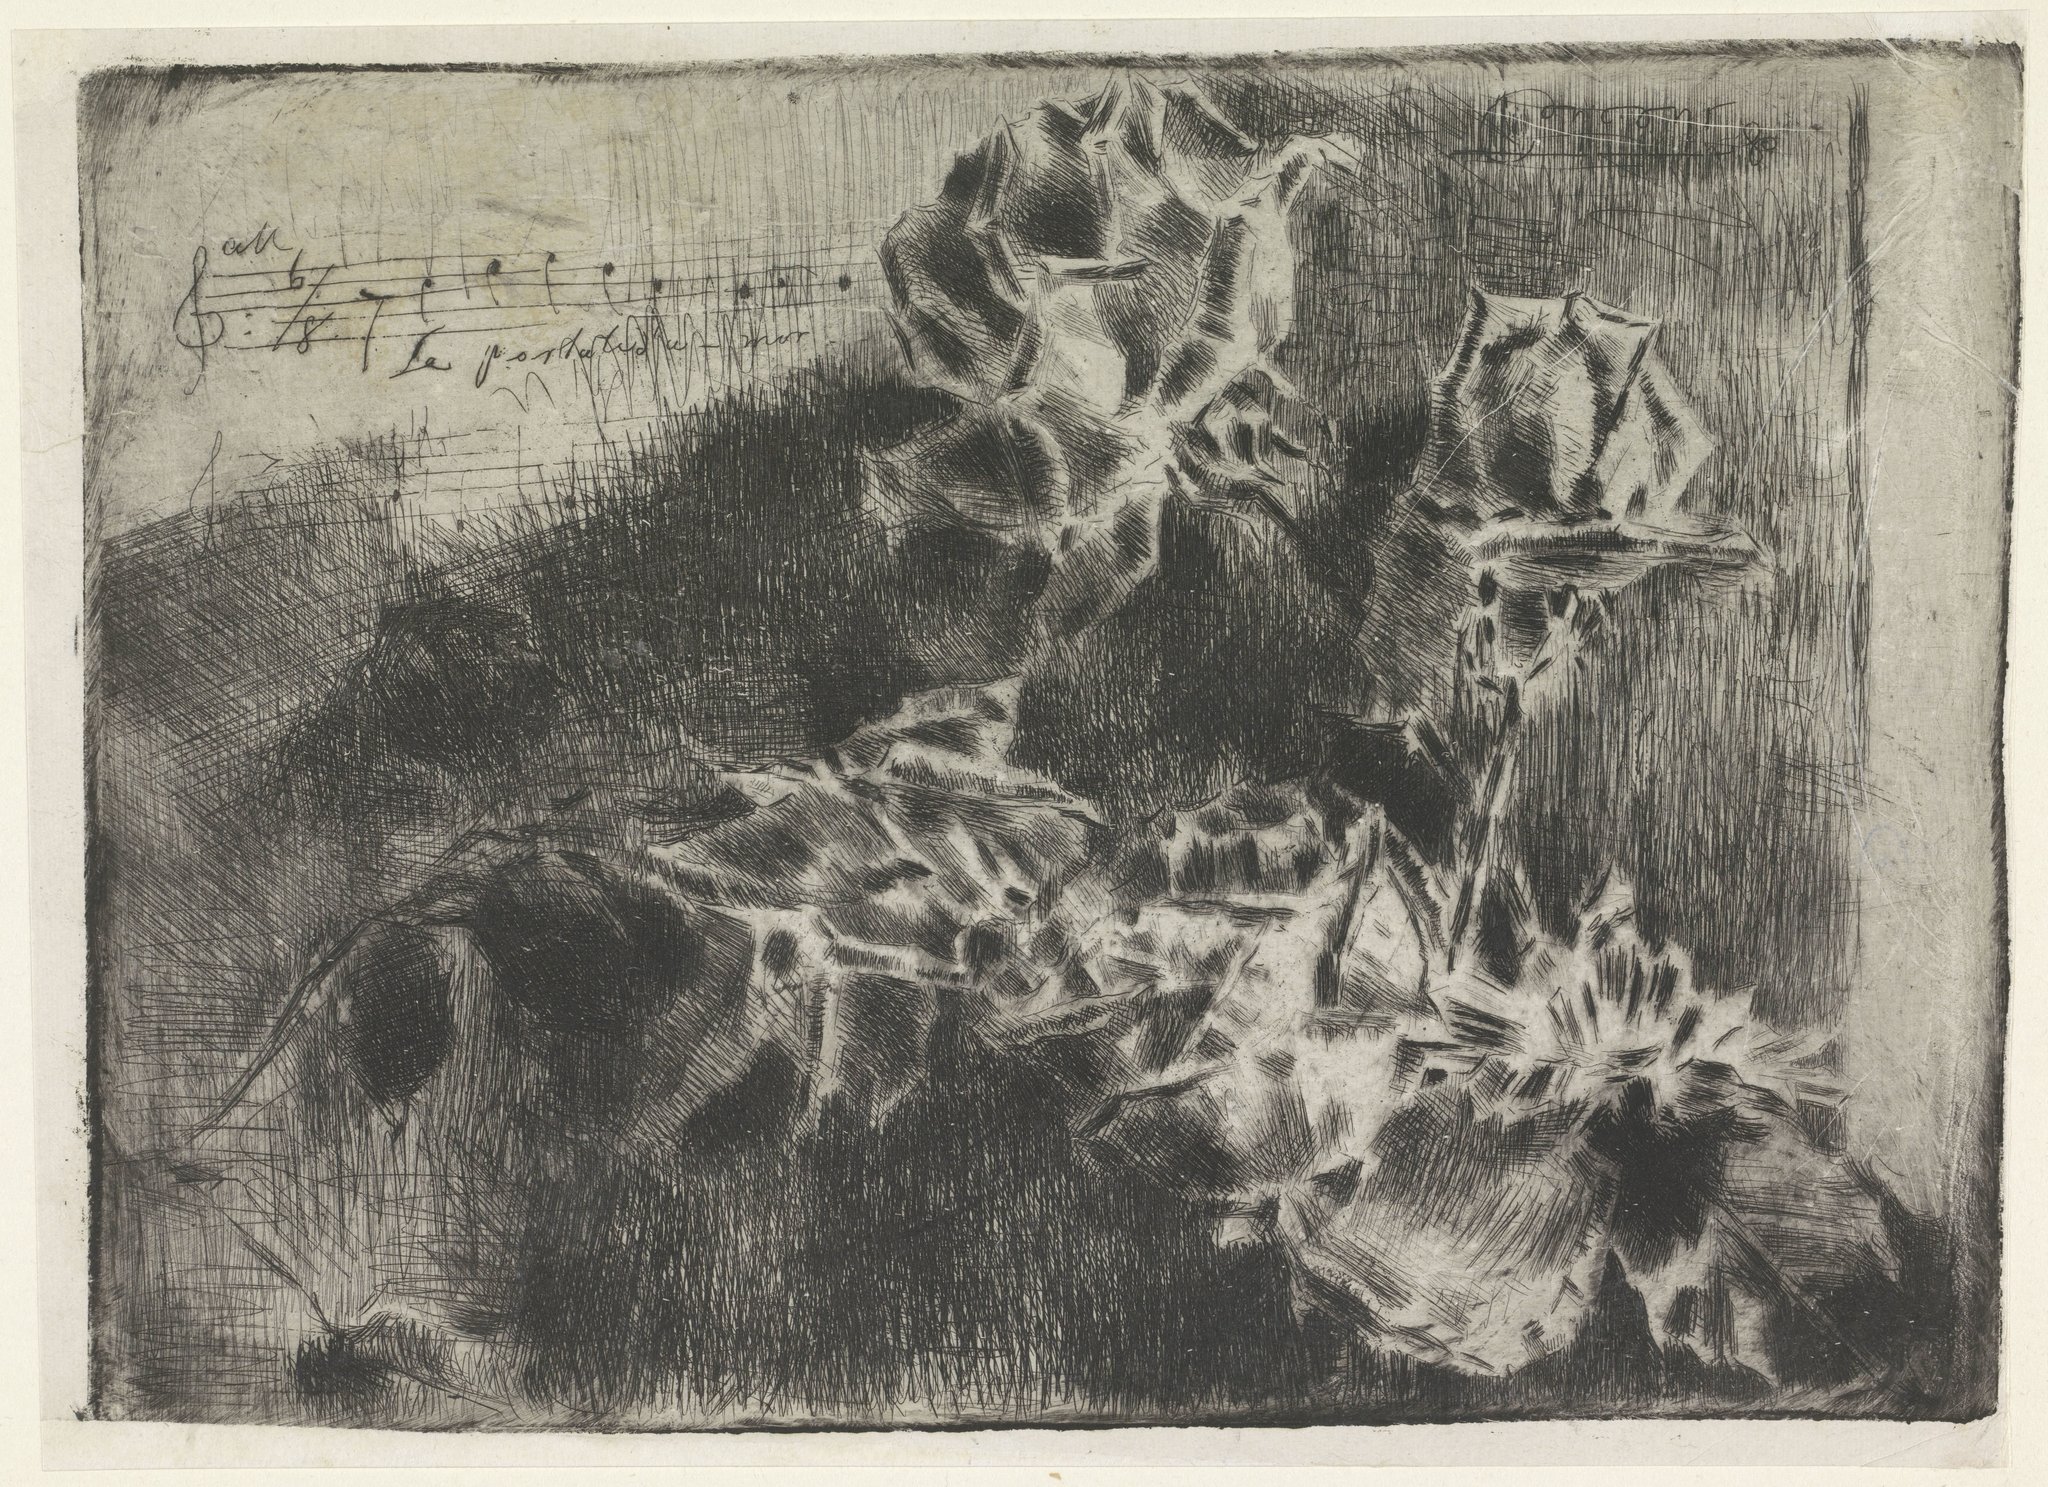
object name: print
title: Rozentak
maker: luigi conconi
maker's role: painter, print maker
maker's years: 1852-1917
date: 1862-1886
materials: paper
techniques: etching, intaglio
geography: italy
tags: notation of music, flowers: rose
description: Een rozentak met twee rozen. Linksboven een notenbalk met daaronder de tekst: le parlate d'amor.